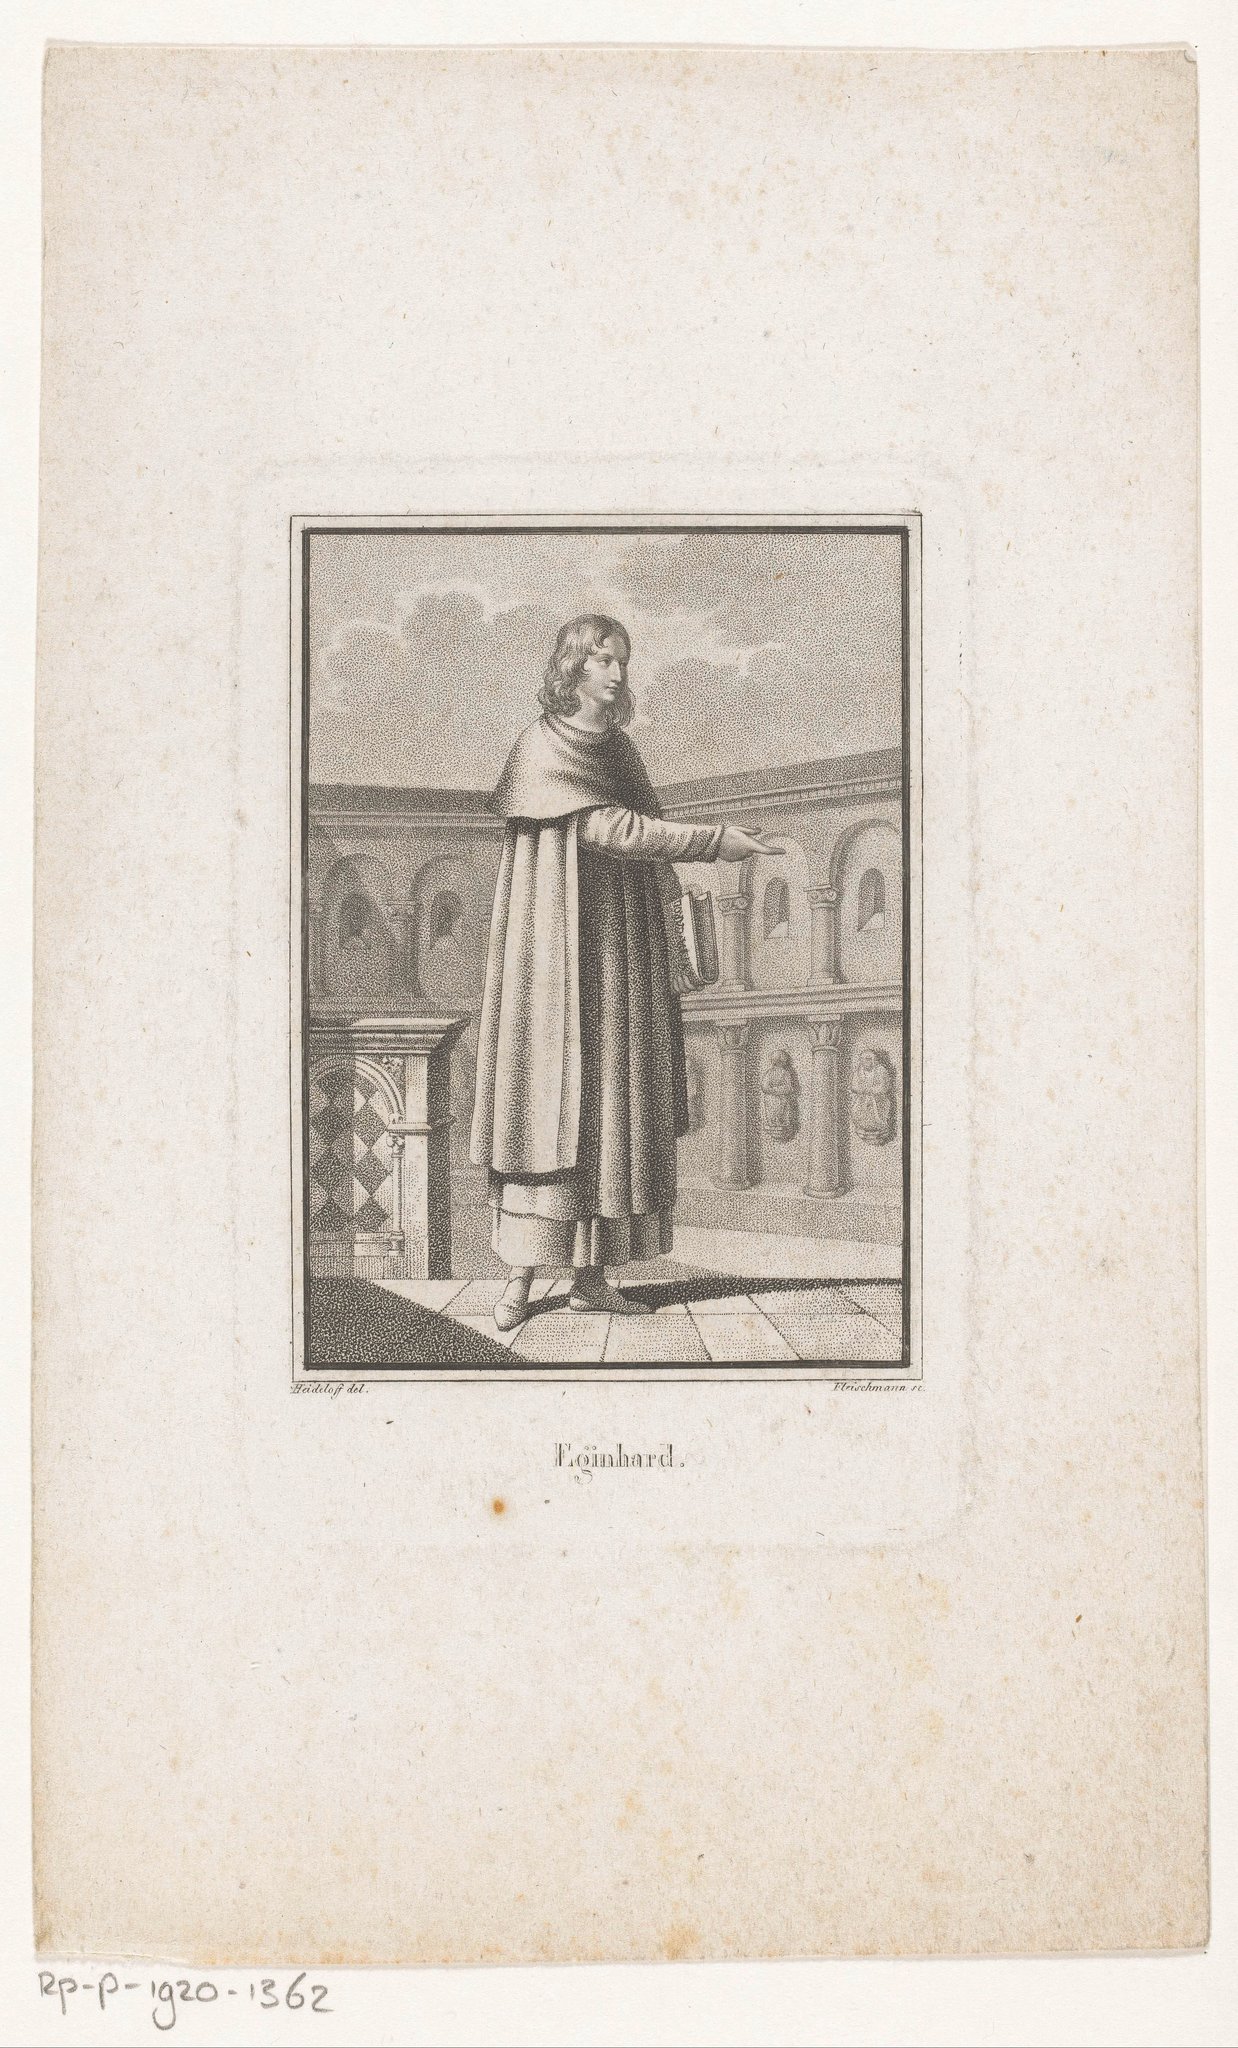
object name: book illustration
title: Portret van Eginhard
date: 1821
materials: paper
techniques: stippling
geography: nuremberg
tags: charlemagne (holy roman emperor), historical persons, book, index finger forwards, pointing, indicating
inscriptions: collector's mark: Lugt 2228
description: Prent gebruikt voor: Jerrer, Georg Ludwig. Geschichte der Teutschen für die Jugend (...). Neurenberg: Friedrich Campe, 1821.